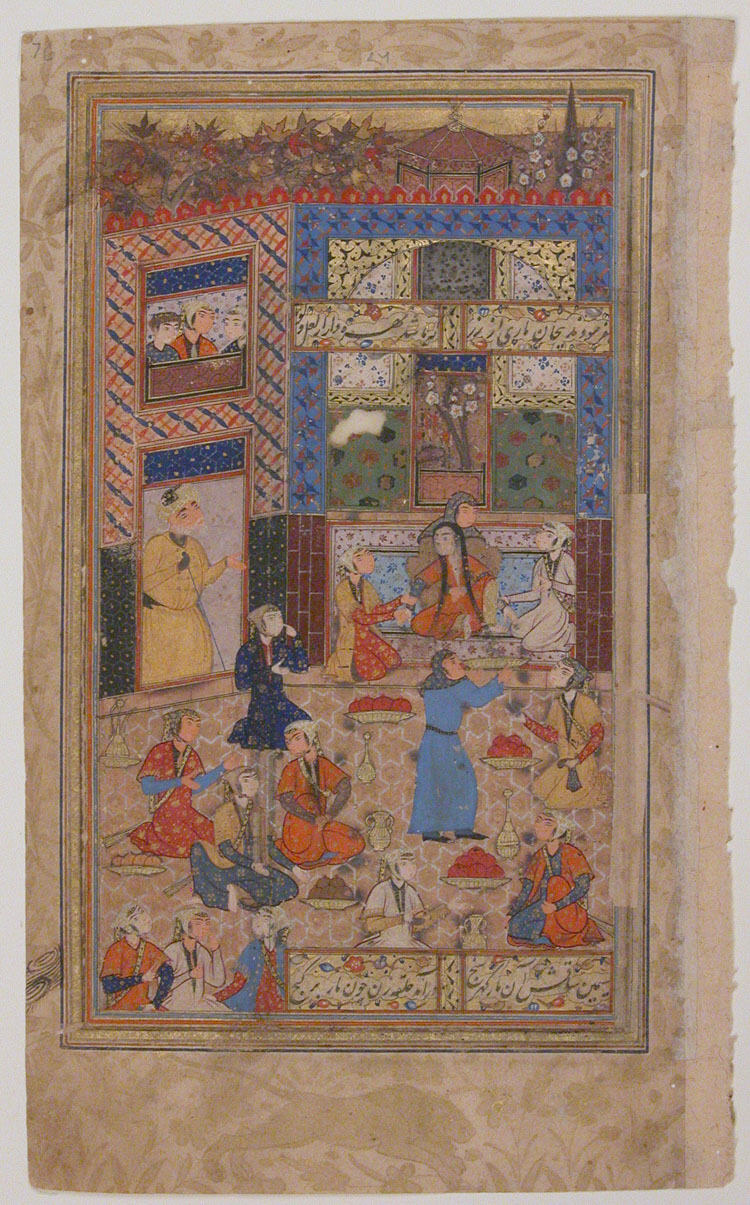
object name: folio from an illustrated manuscript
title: "Zulaikha after her Second Dream of Yusuf", Folio from a Yusuf and Zulaikha of Jami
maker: maulana nur al-din `abd al-rahman jami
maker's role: author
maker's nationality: iranian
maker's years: 1414-1492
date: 1551-1600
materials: gold, paper, watercolor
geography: iran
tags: men,women